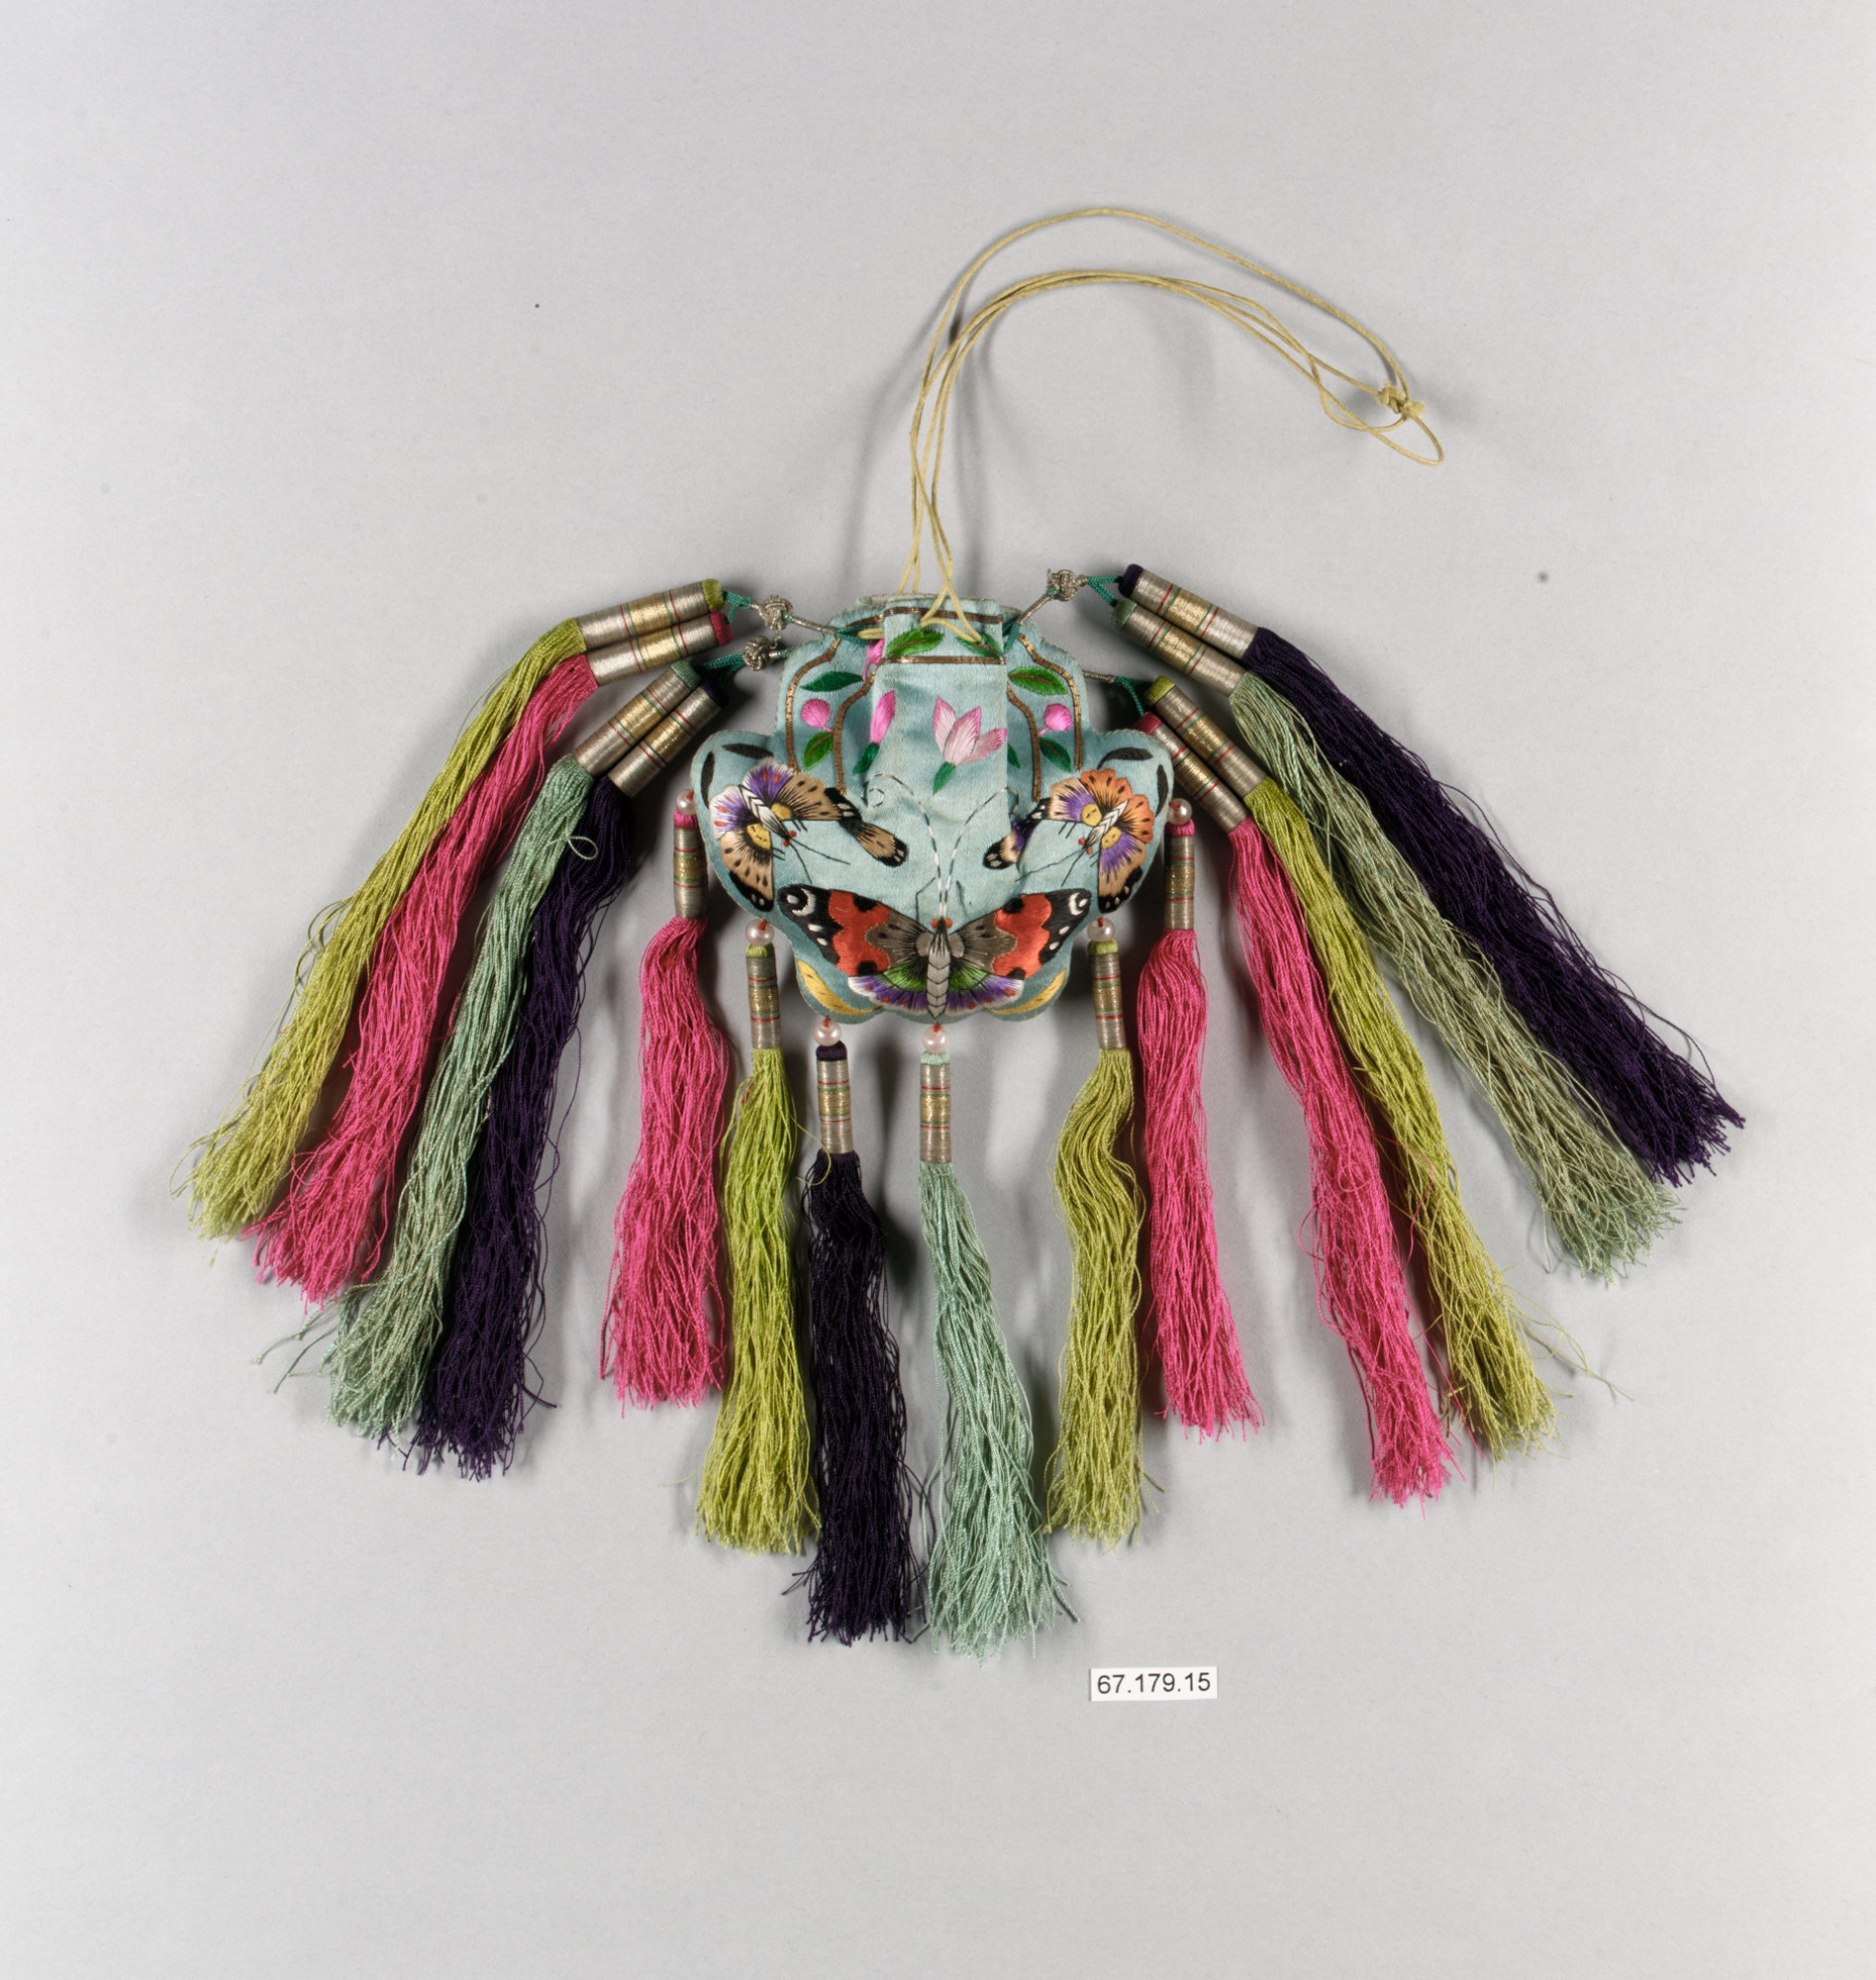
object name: purse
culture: chinese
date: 1801-1900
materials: metal thread, silk